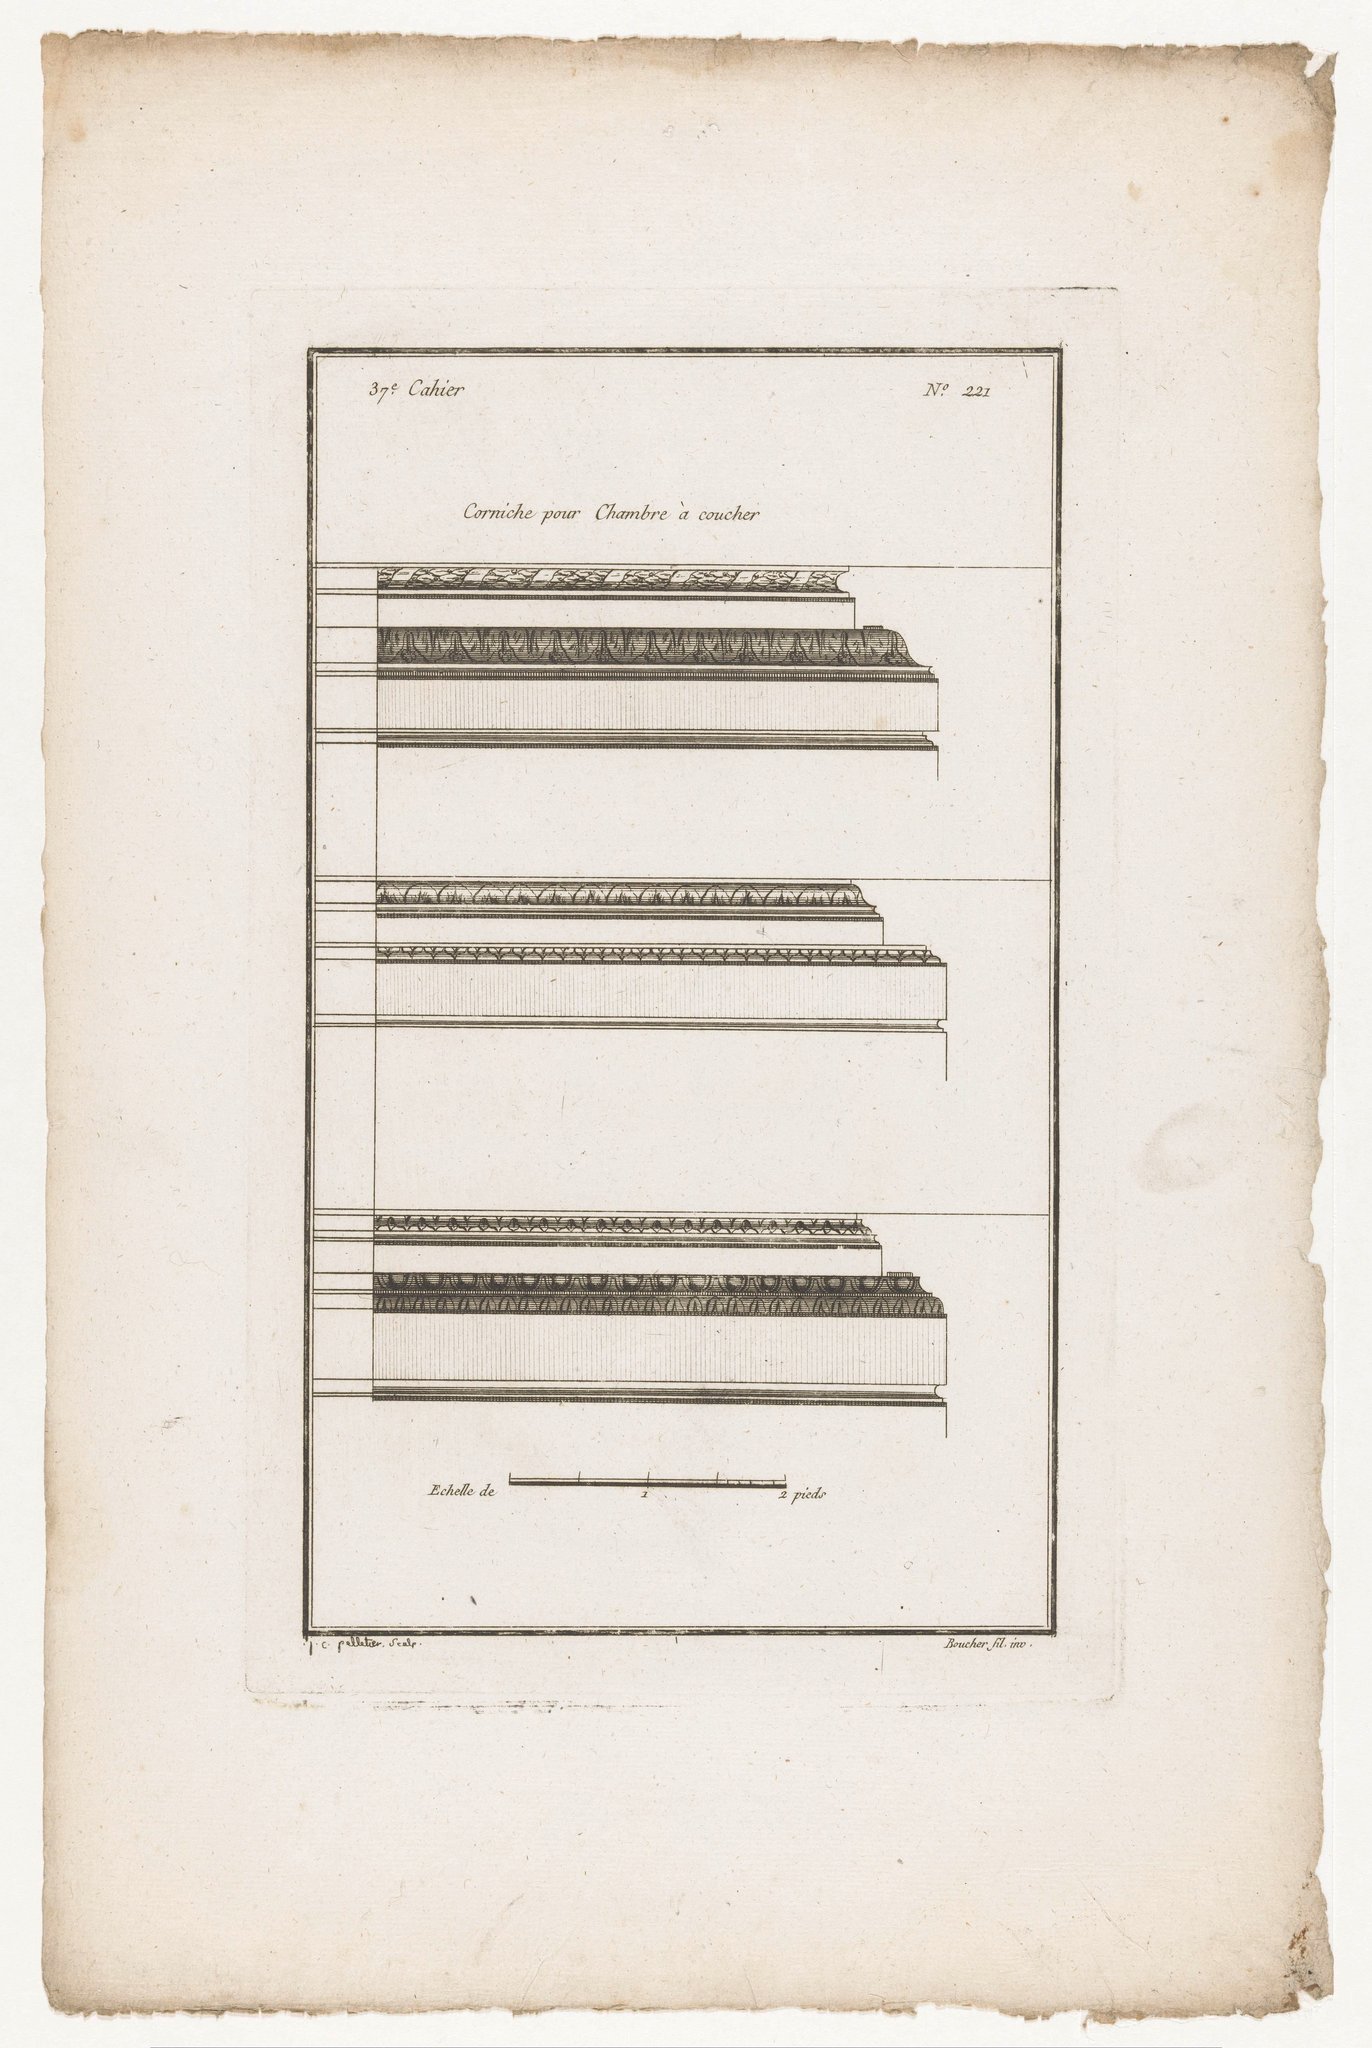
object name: ornament print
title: 37e Cahier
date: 1772-1779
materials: paper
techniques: engraving, etching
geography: paris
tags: other architectural details (cornice)